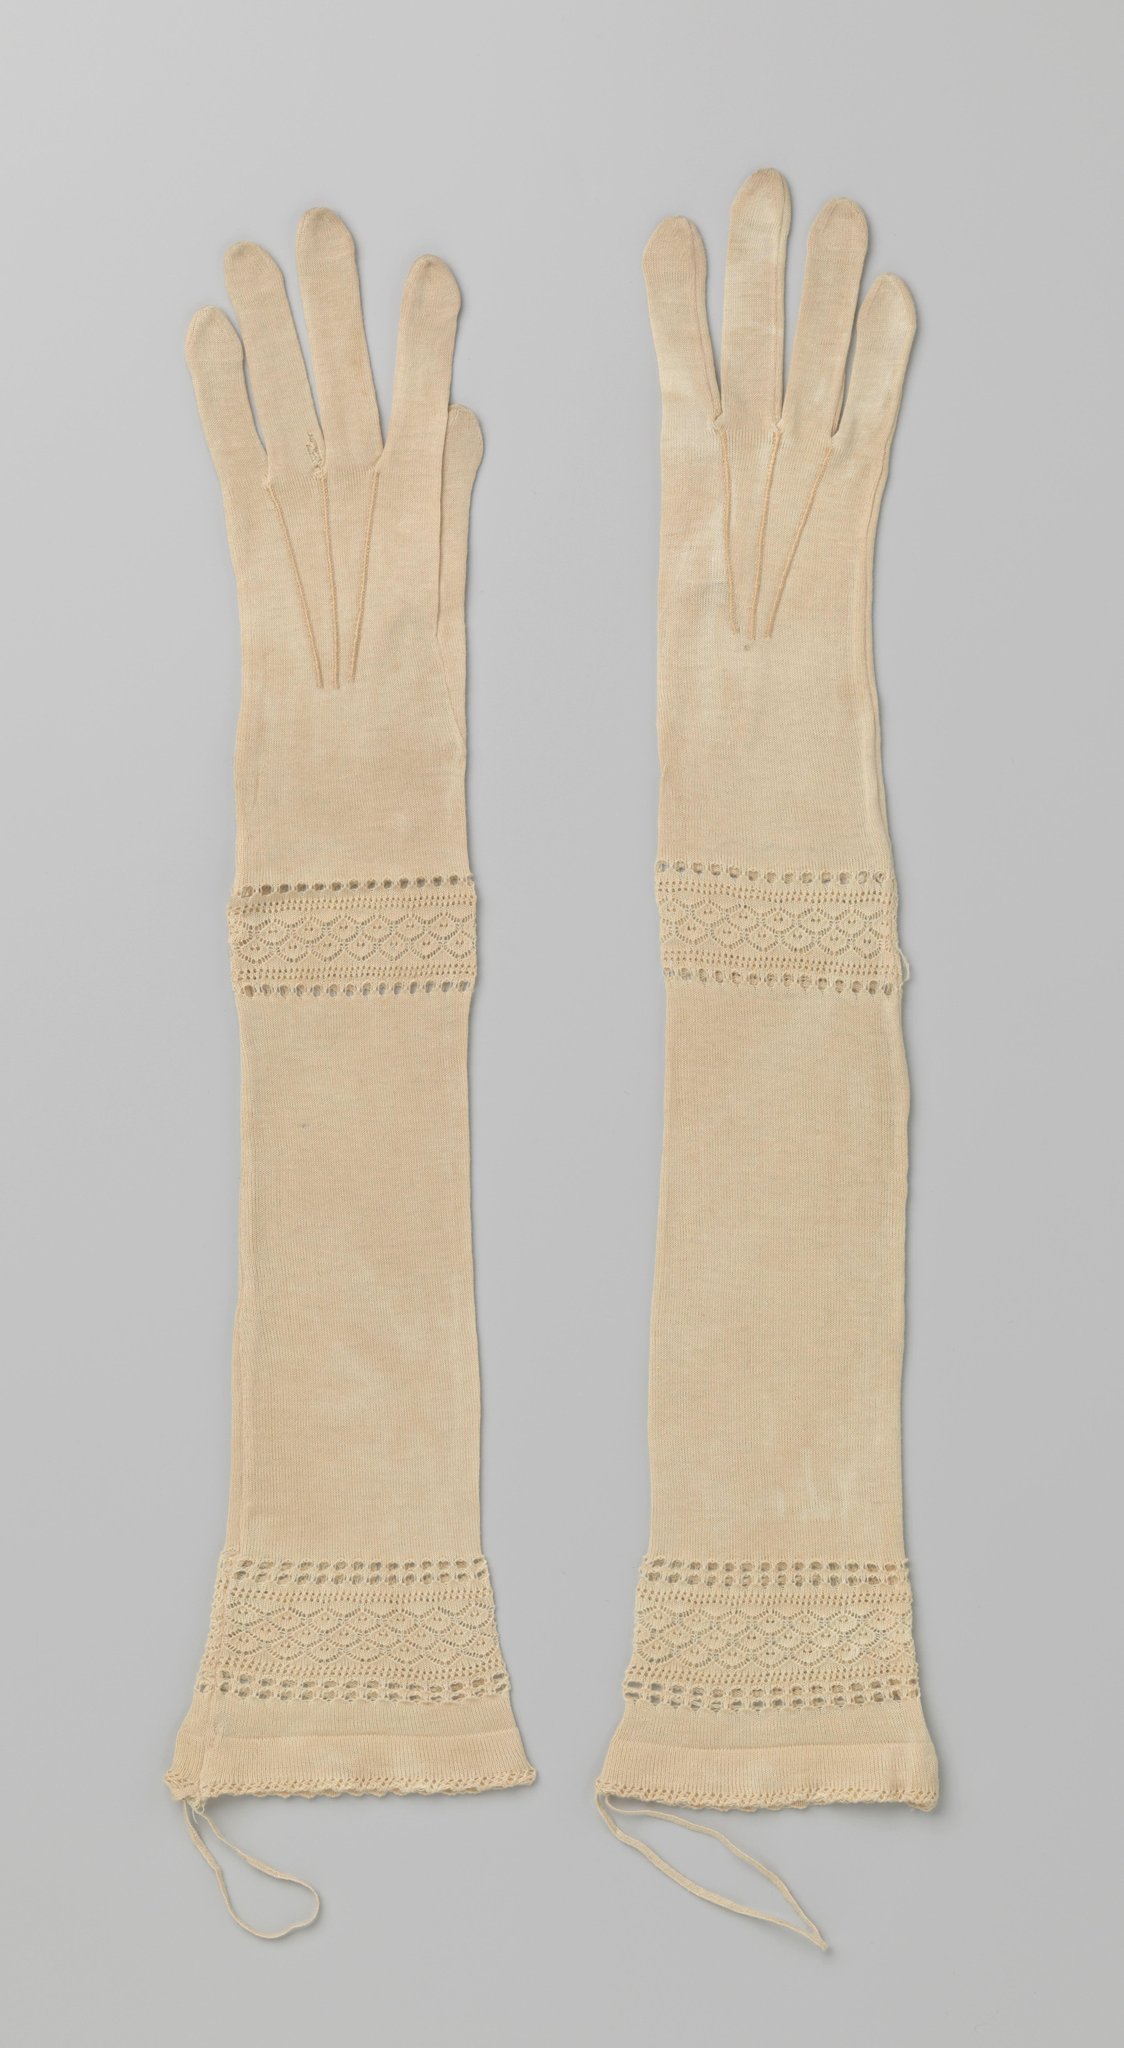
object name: clothing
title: Handschoen in crèmekleurige katoen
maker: Anonymous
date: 1880-1900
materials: cotton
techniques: embroidery, knitting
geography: netherlands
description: Rechterhandschoen van crèmekleurige katoen, met ajour breiwerk ter hoogte van de pols. Boord met striklint, bovenzijde geschulpt met op de hand drie uitstralende koorden.